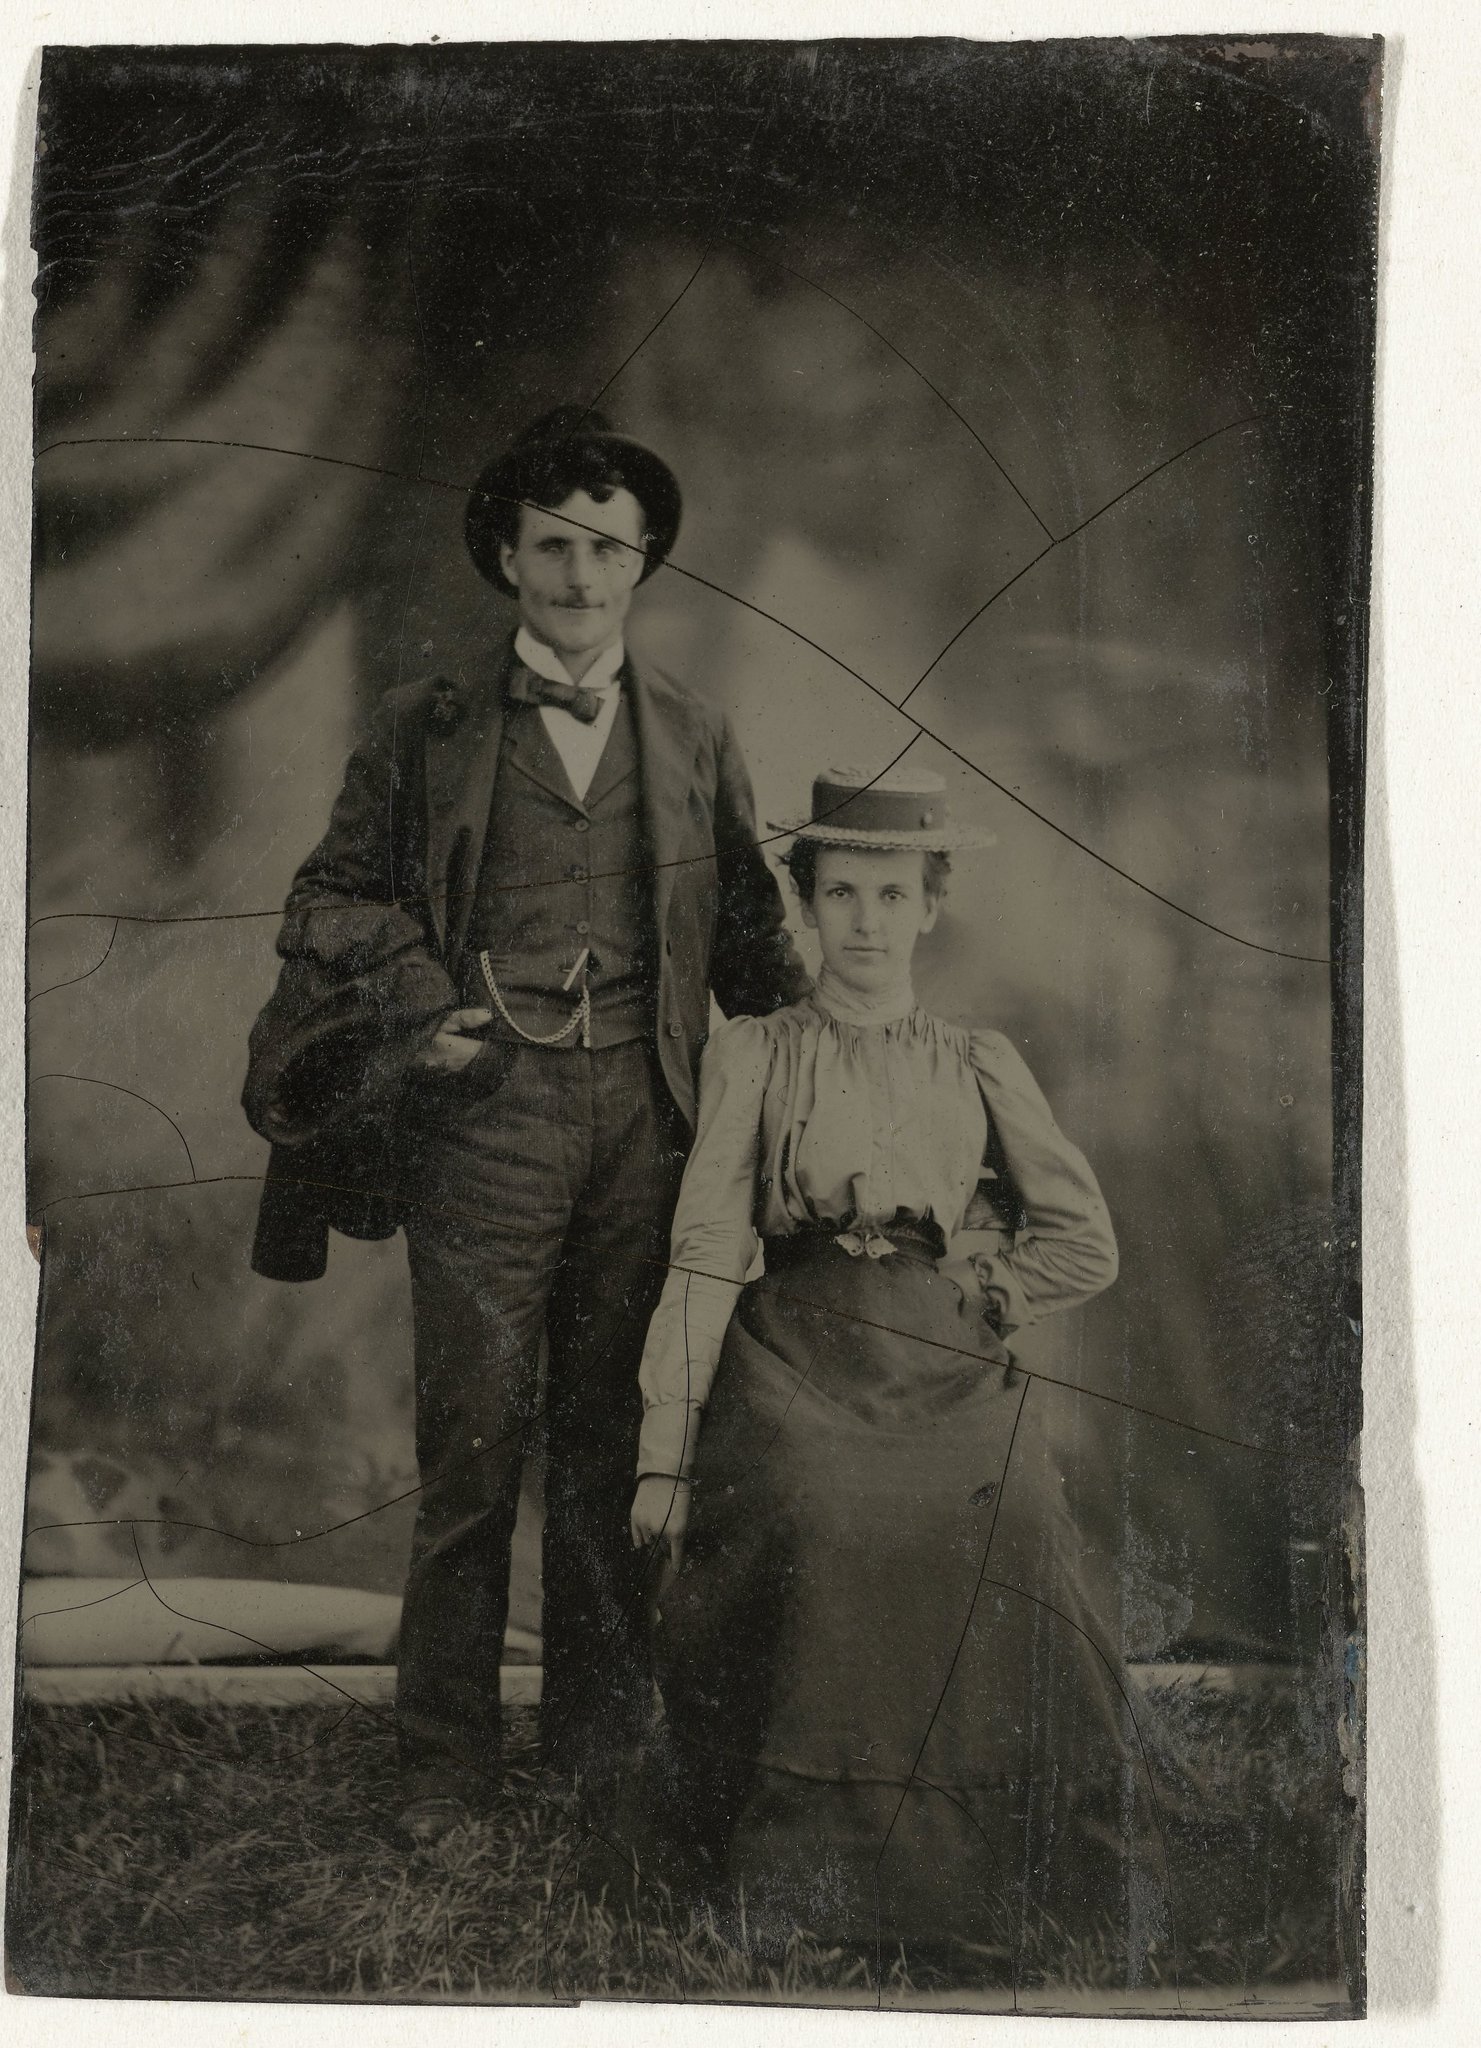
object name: photograph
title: Portret van een man en een vrouw (James A. McKay en Belle Savage-Reed (of Savage-Reed)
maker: Anonymous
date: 1890-1910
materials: metal, paper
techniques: ferrotyping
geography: united states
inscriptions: annotation: ‘(James A. McKay) / Papa and Aunt Belle (Reed) / Savage’